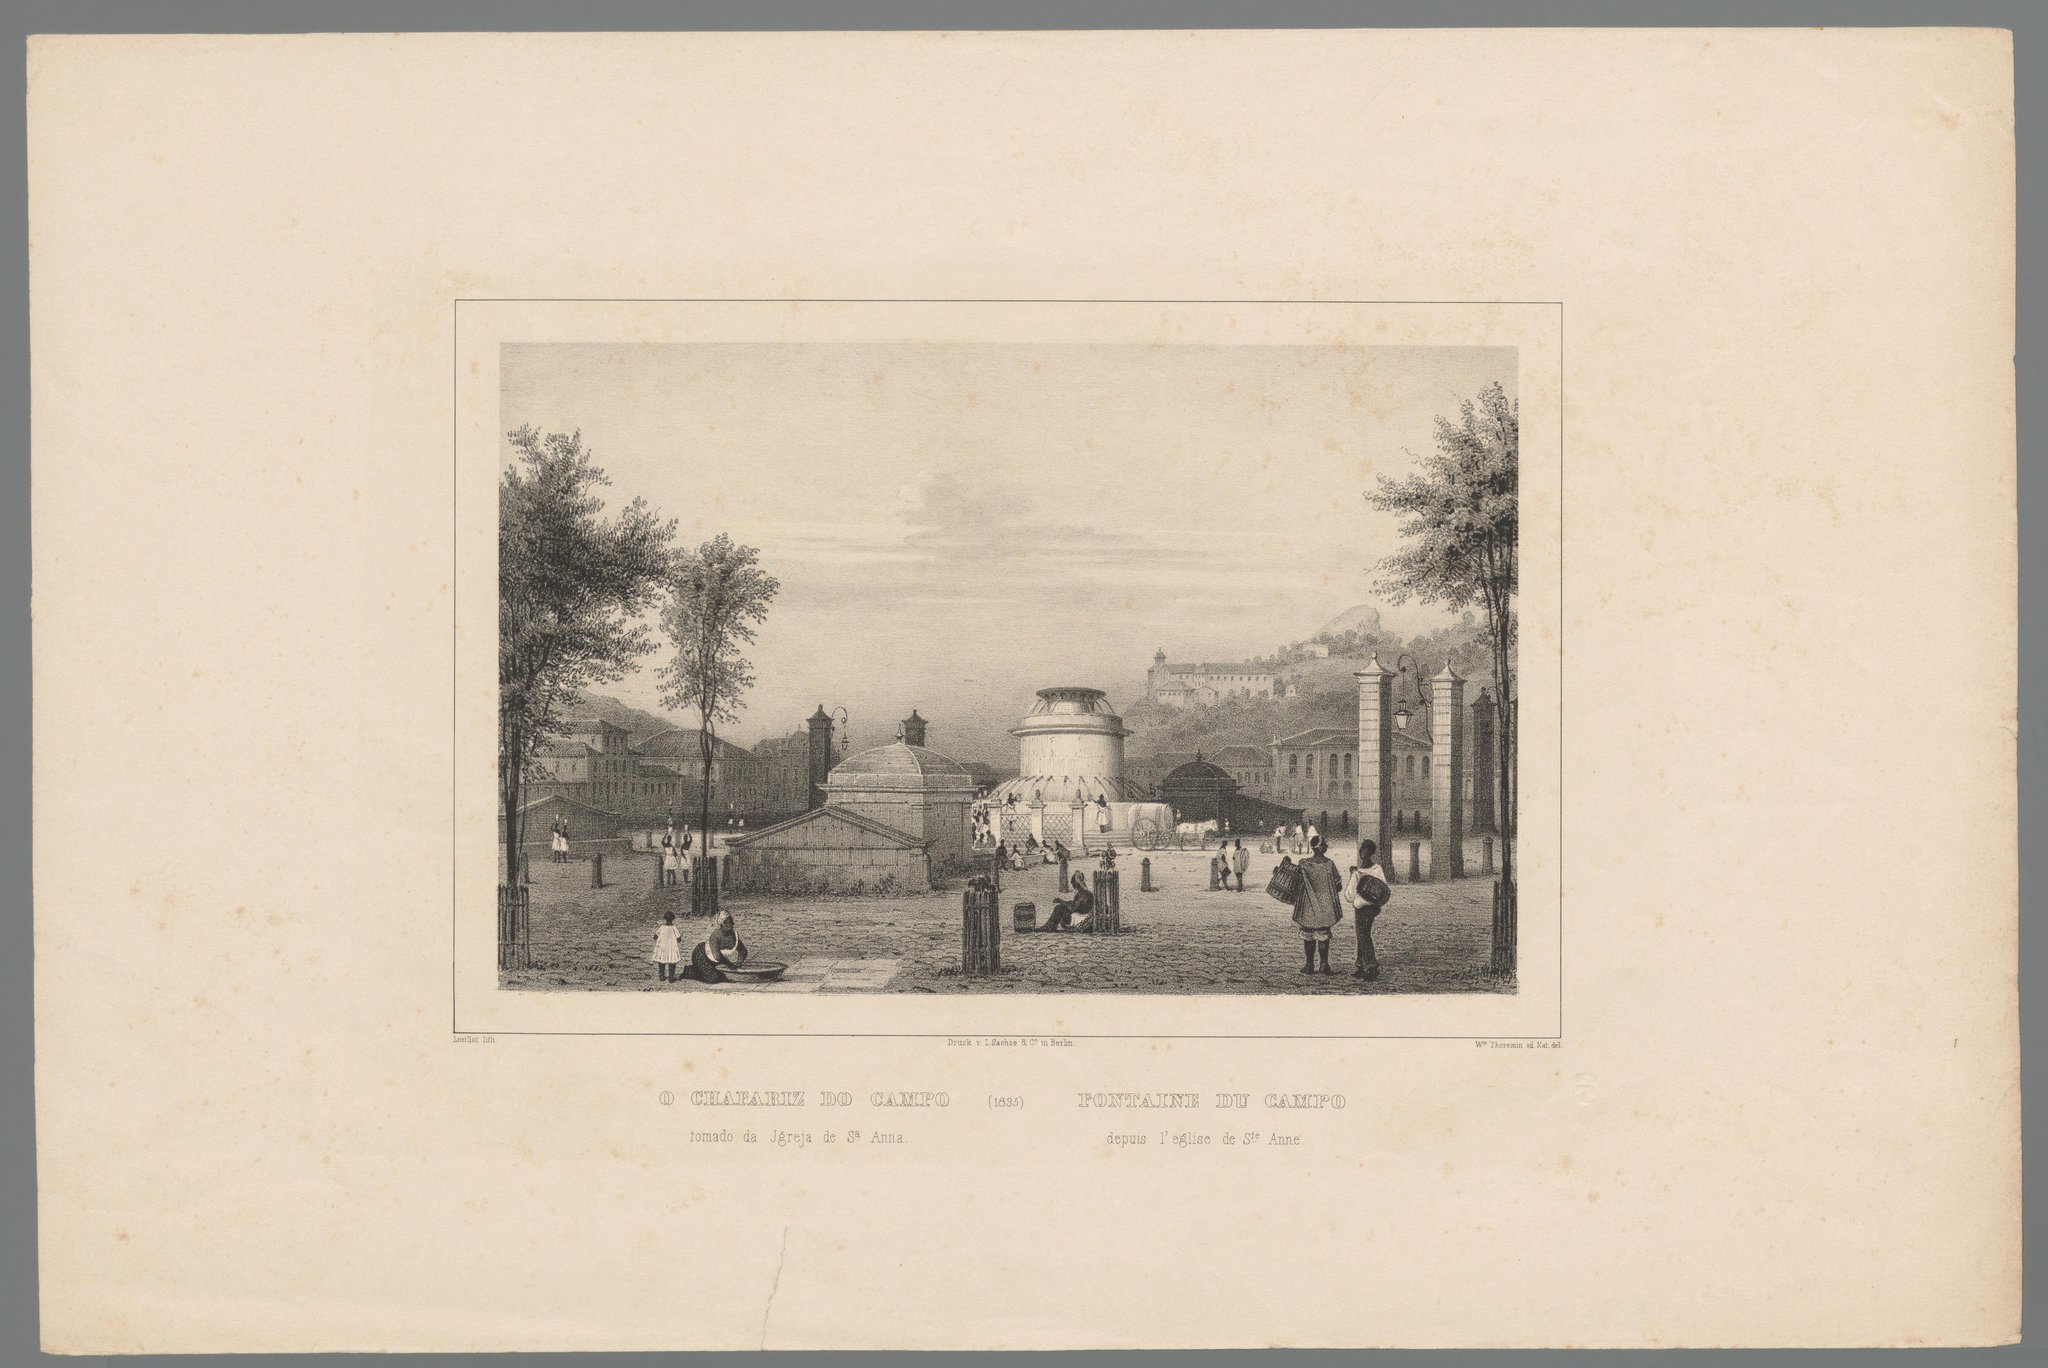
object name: print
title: O Chafariz do Campo / Fontaine du Campo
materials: paper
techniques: lithograph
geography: berlin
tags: ornamental fountain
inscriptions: check stamp: ‘T’, collector's mark: Lugt 2228